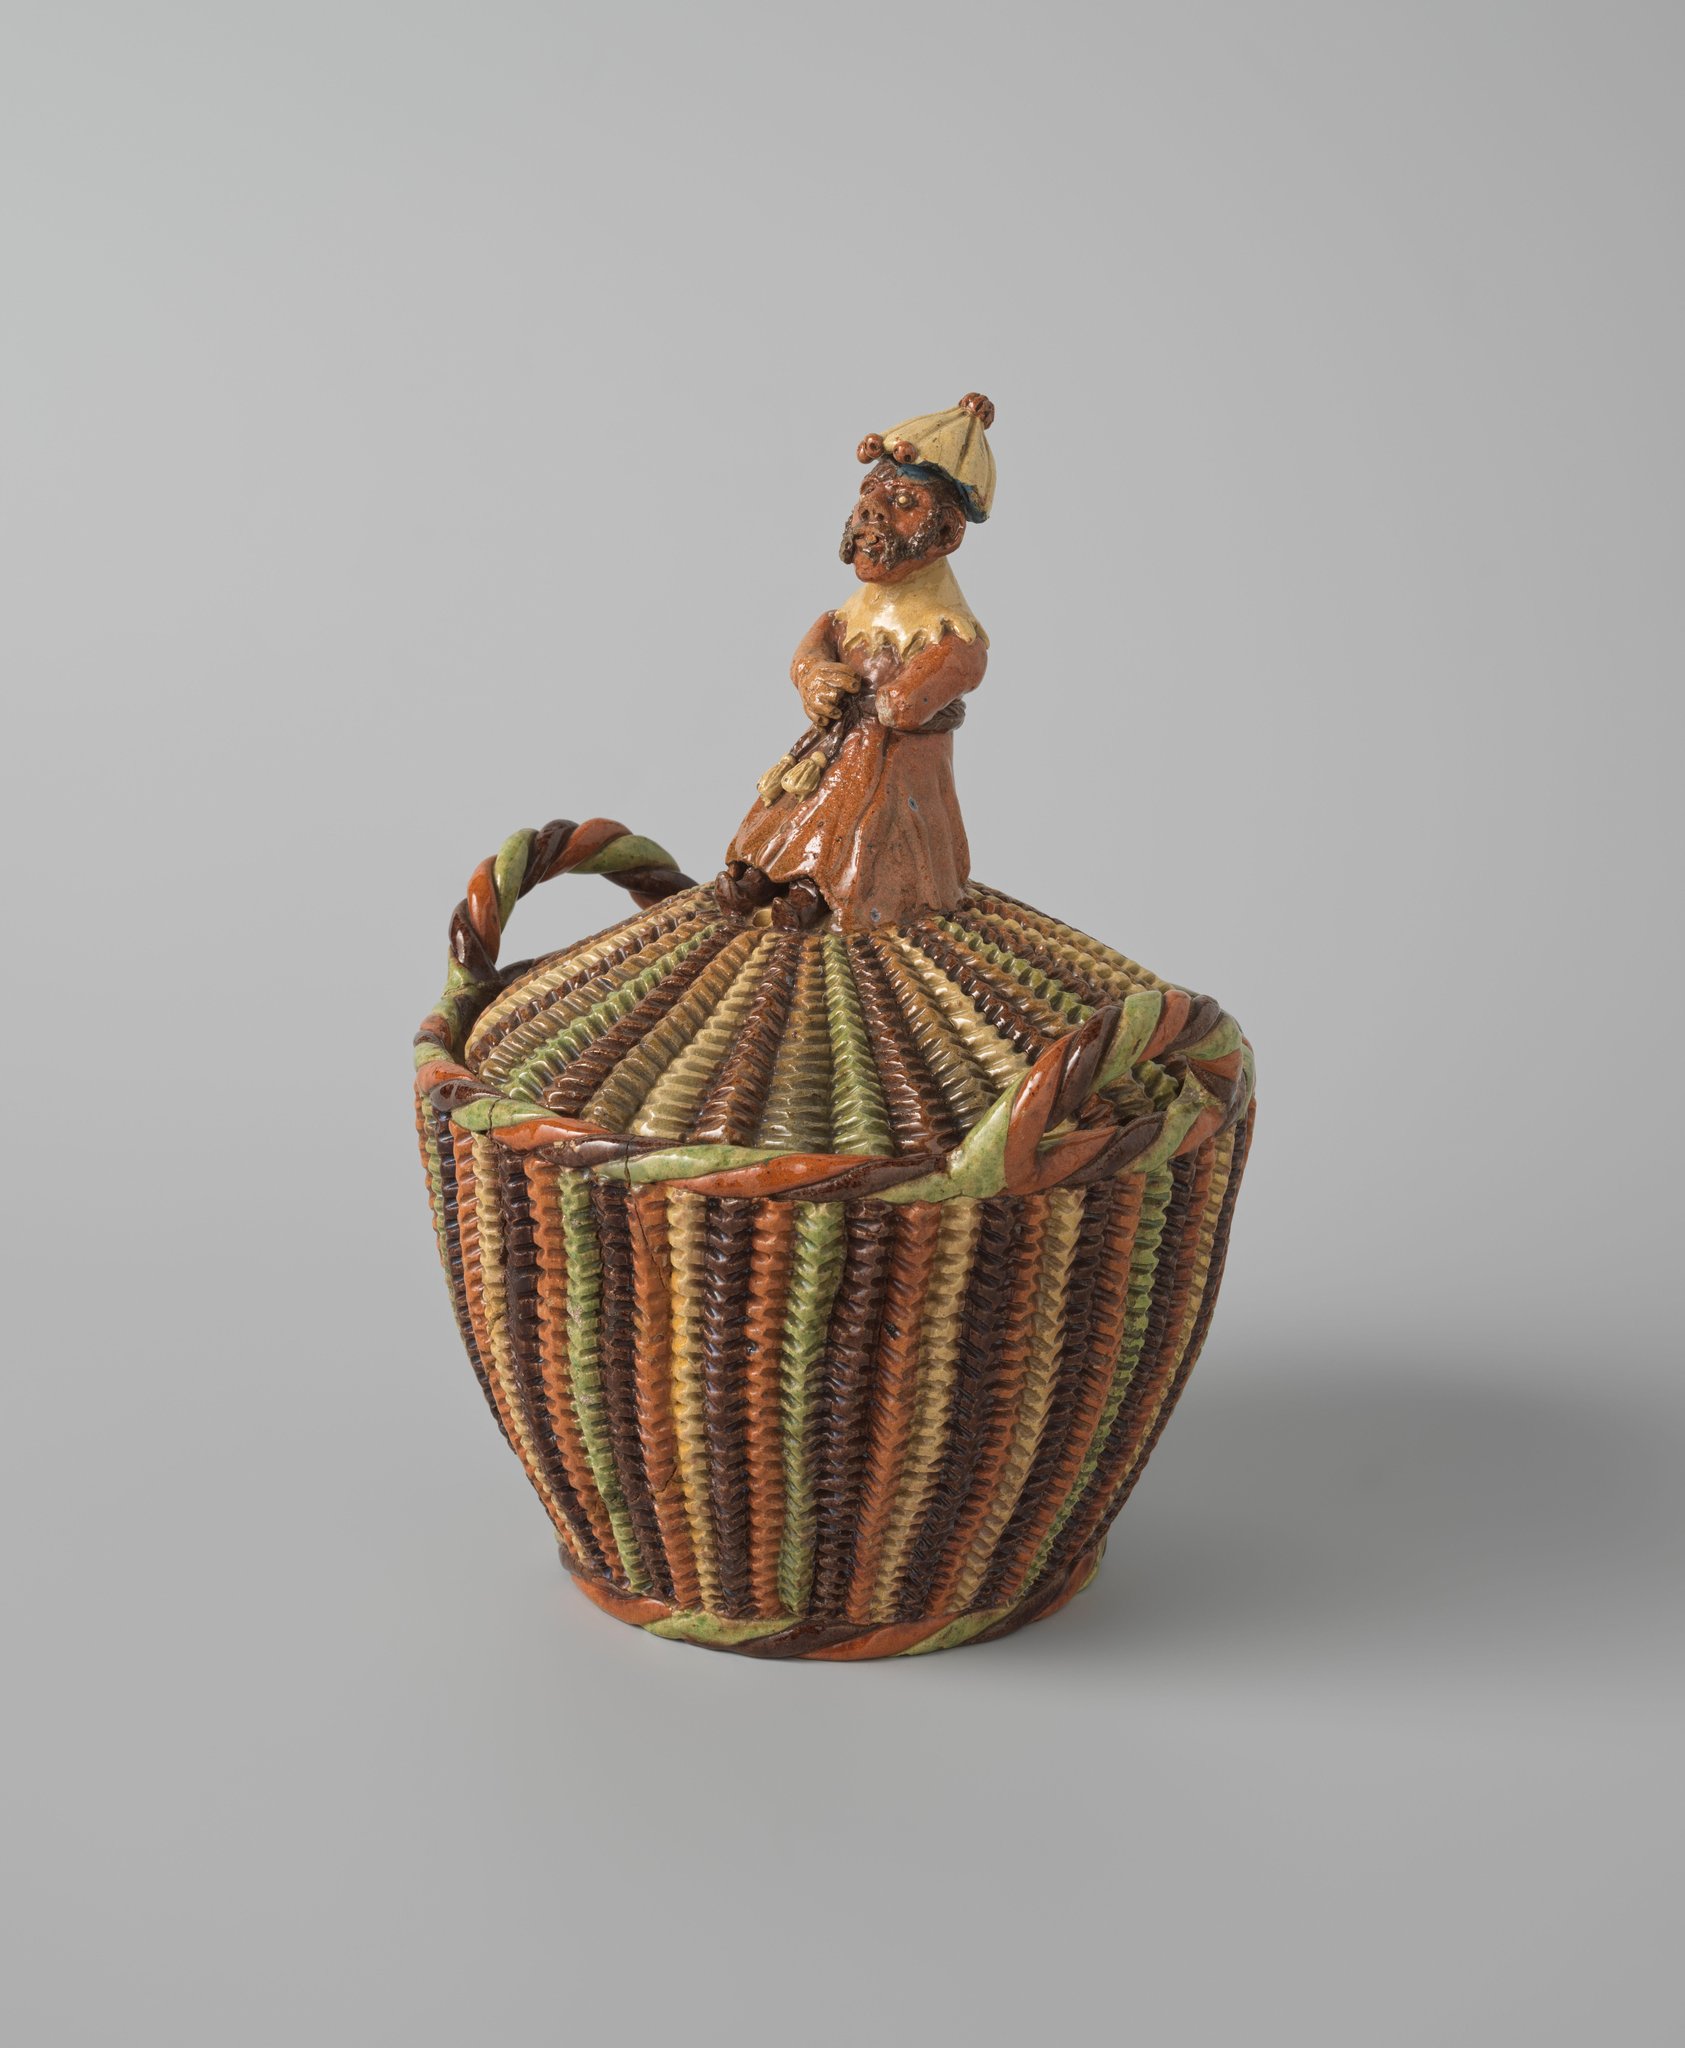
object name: tobacco jar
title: Tabakspot van polychroom loodglazuuraardewerk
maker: ceradus van de raa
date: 1825-1875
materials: earthenware, glaze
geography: tegelen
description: Tabakspot van veelkleurig beschilderd loodglazuuraardewerk. De pot is een mand met twee handvatten en een deksel. Op het deksel staat een man. Opschrift: Ceradus van de Raa.